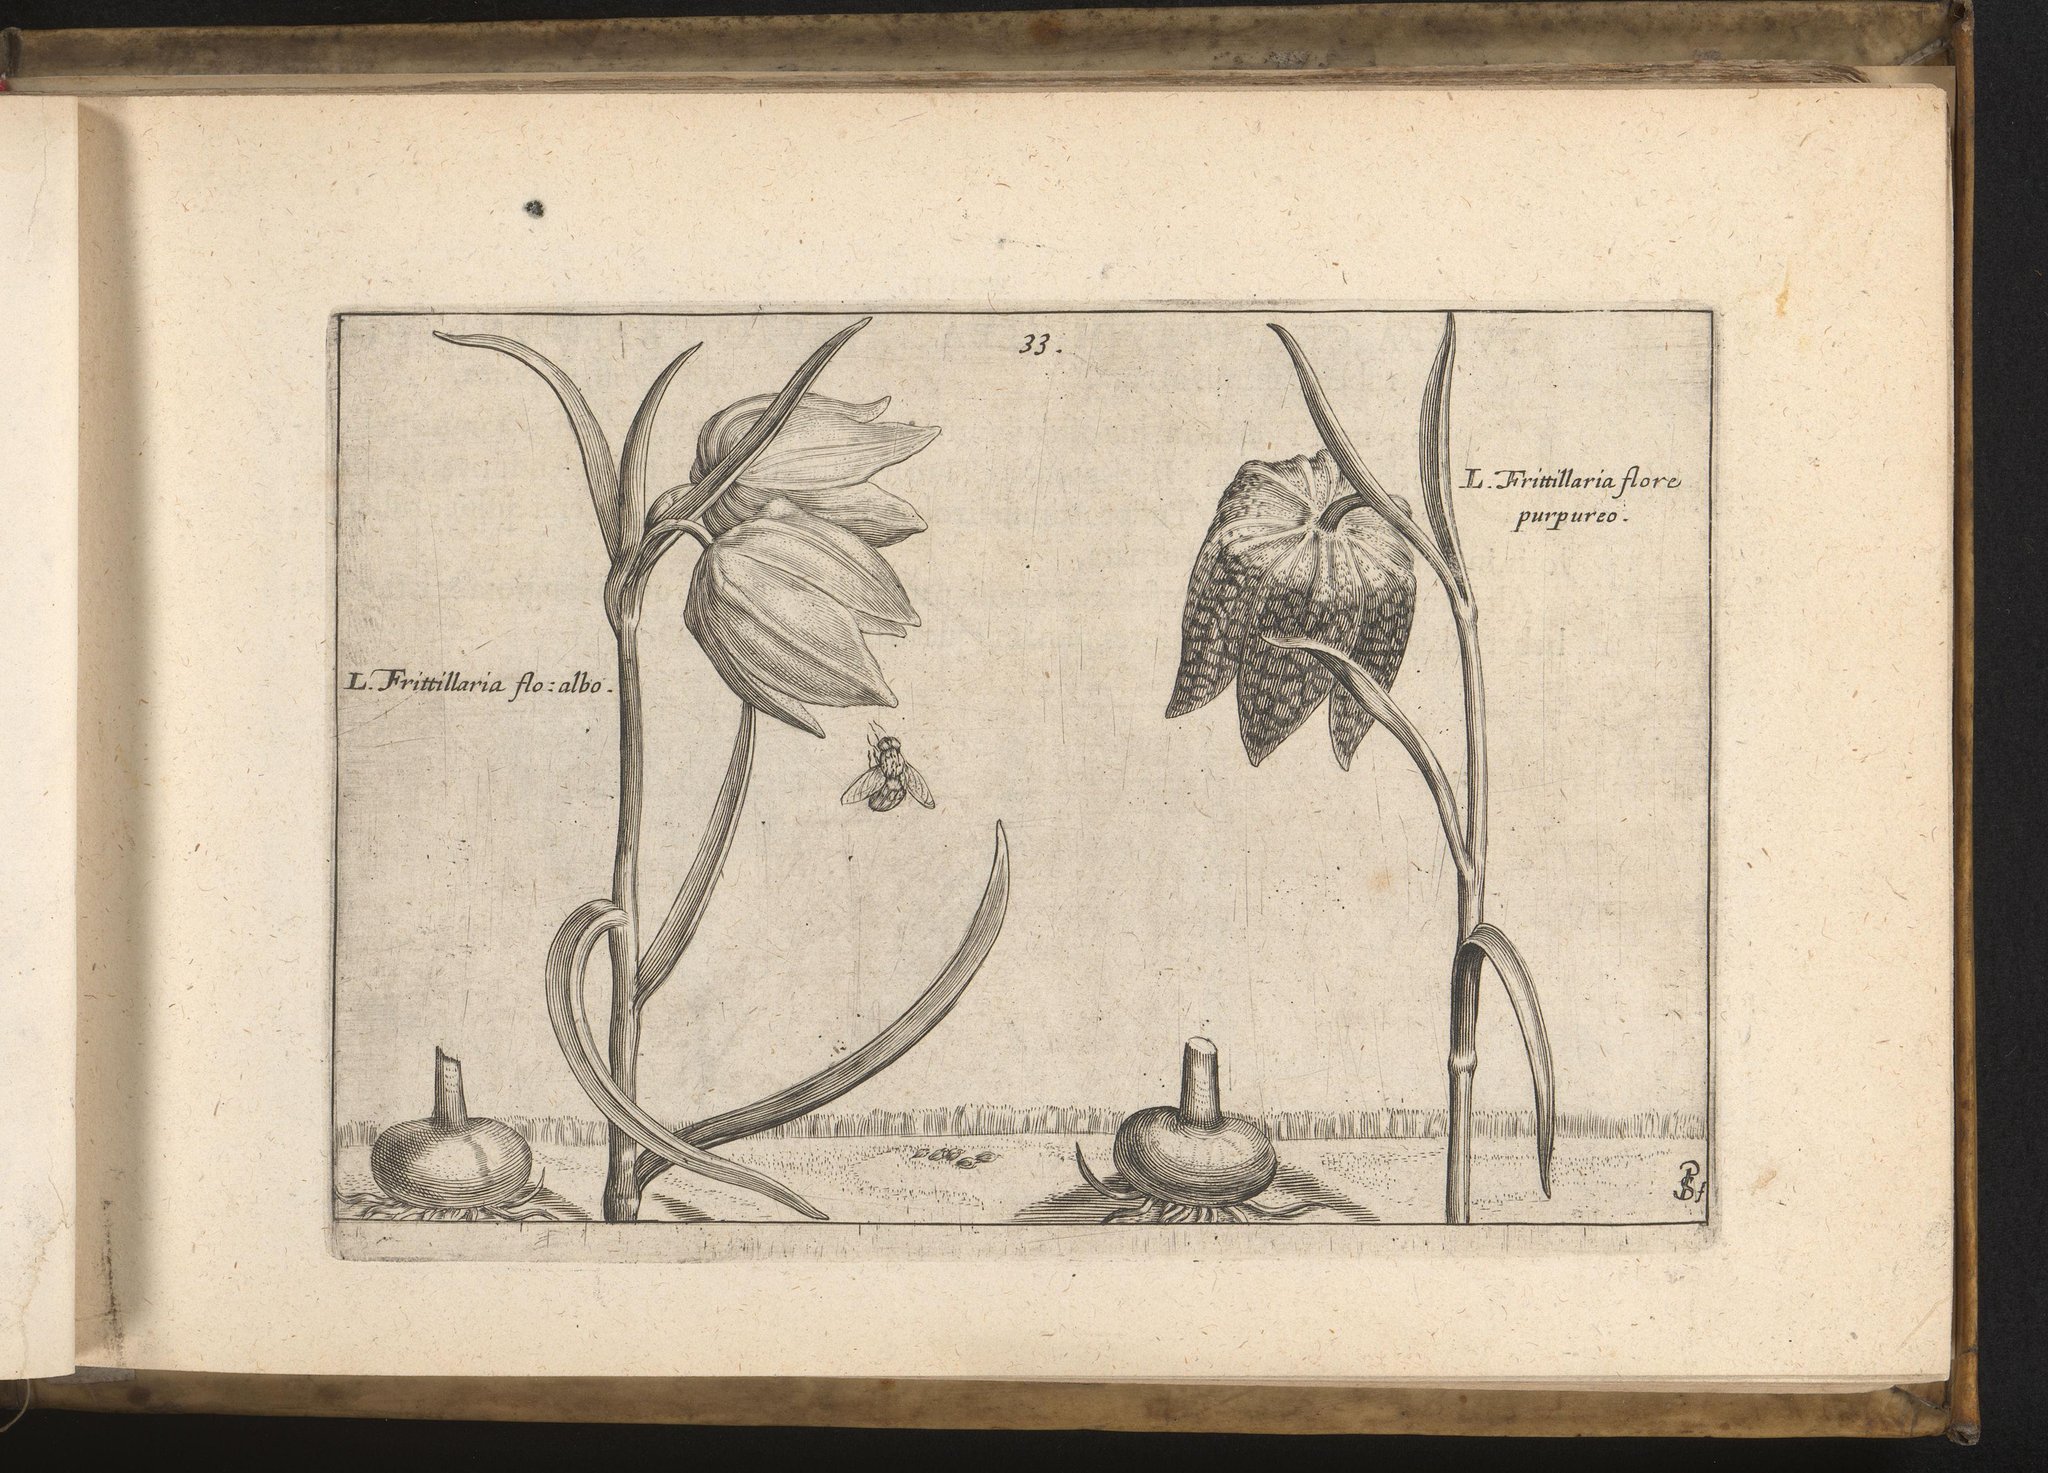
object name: book illustration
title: Horti floridi, vernalis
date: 1617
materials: paper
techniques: engraving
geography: arnhem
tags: flowers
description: Prent uit: Passe, Crispijn van de (II). Hortus floridus in quo rariorum & minus vulgarium florum icones ad vivam veramque formam. Arnhem: Johannes Janssonius, 1617.